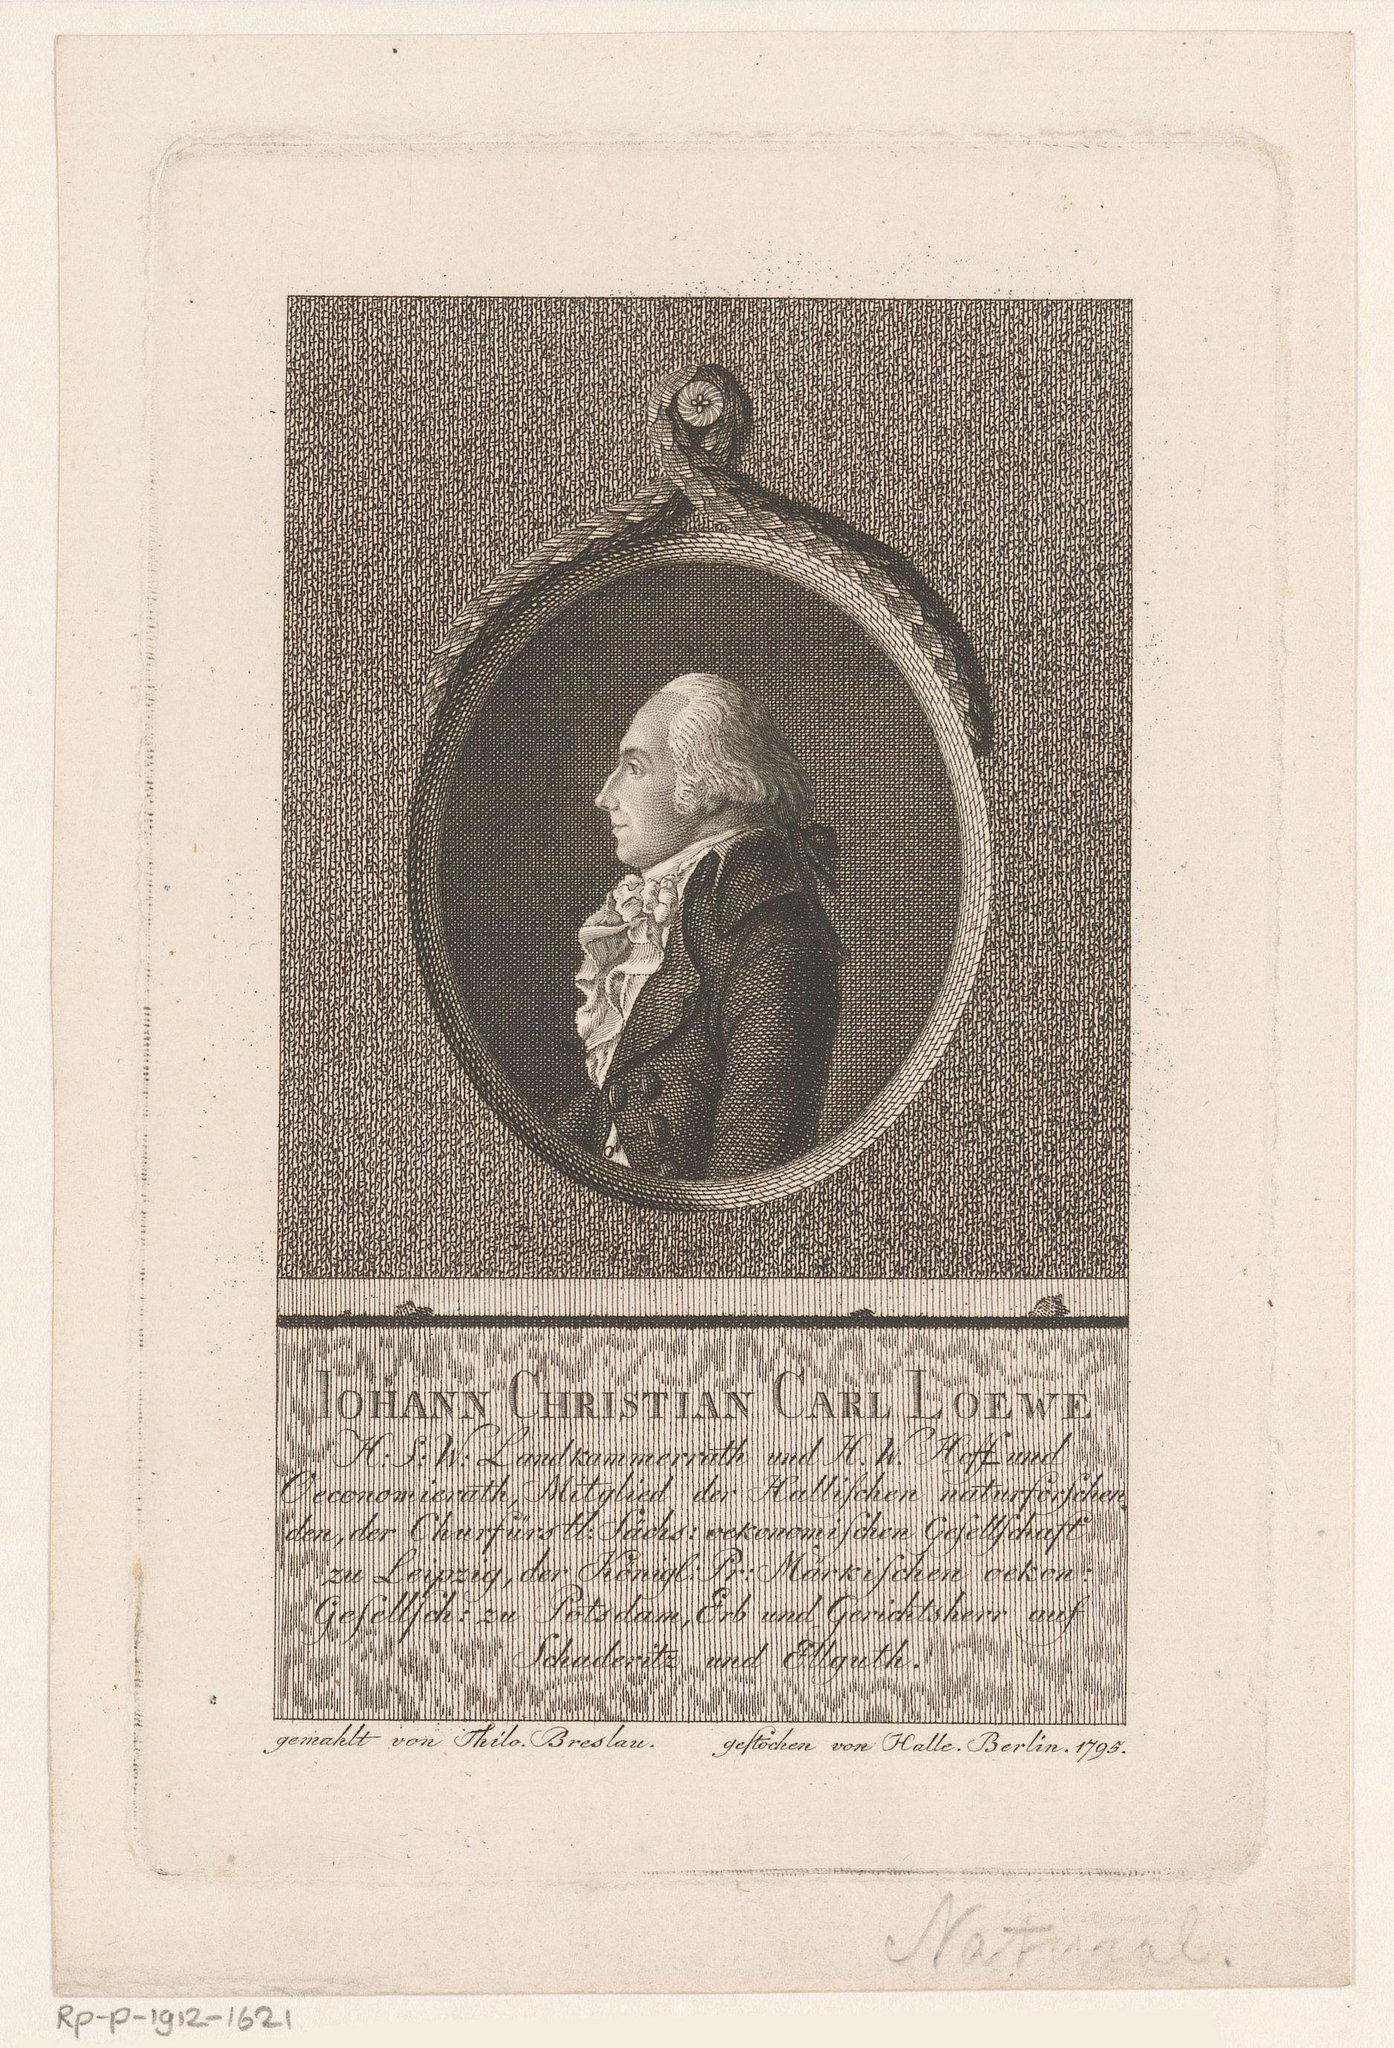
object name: print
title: Portret van Johann Karl Christian Löwe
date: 1795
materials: paper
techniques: engraving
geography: breslau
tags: ornament ~ medallion, historical persons, ornament ~ festoon, garland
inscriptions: collector's mark: Lugt 2228